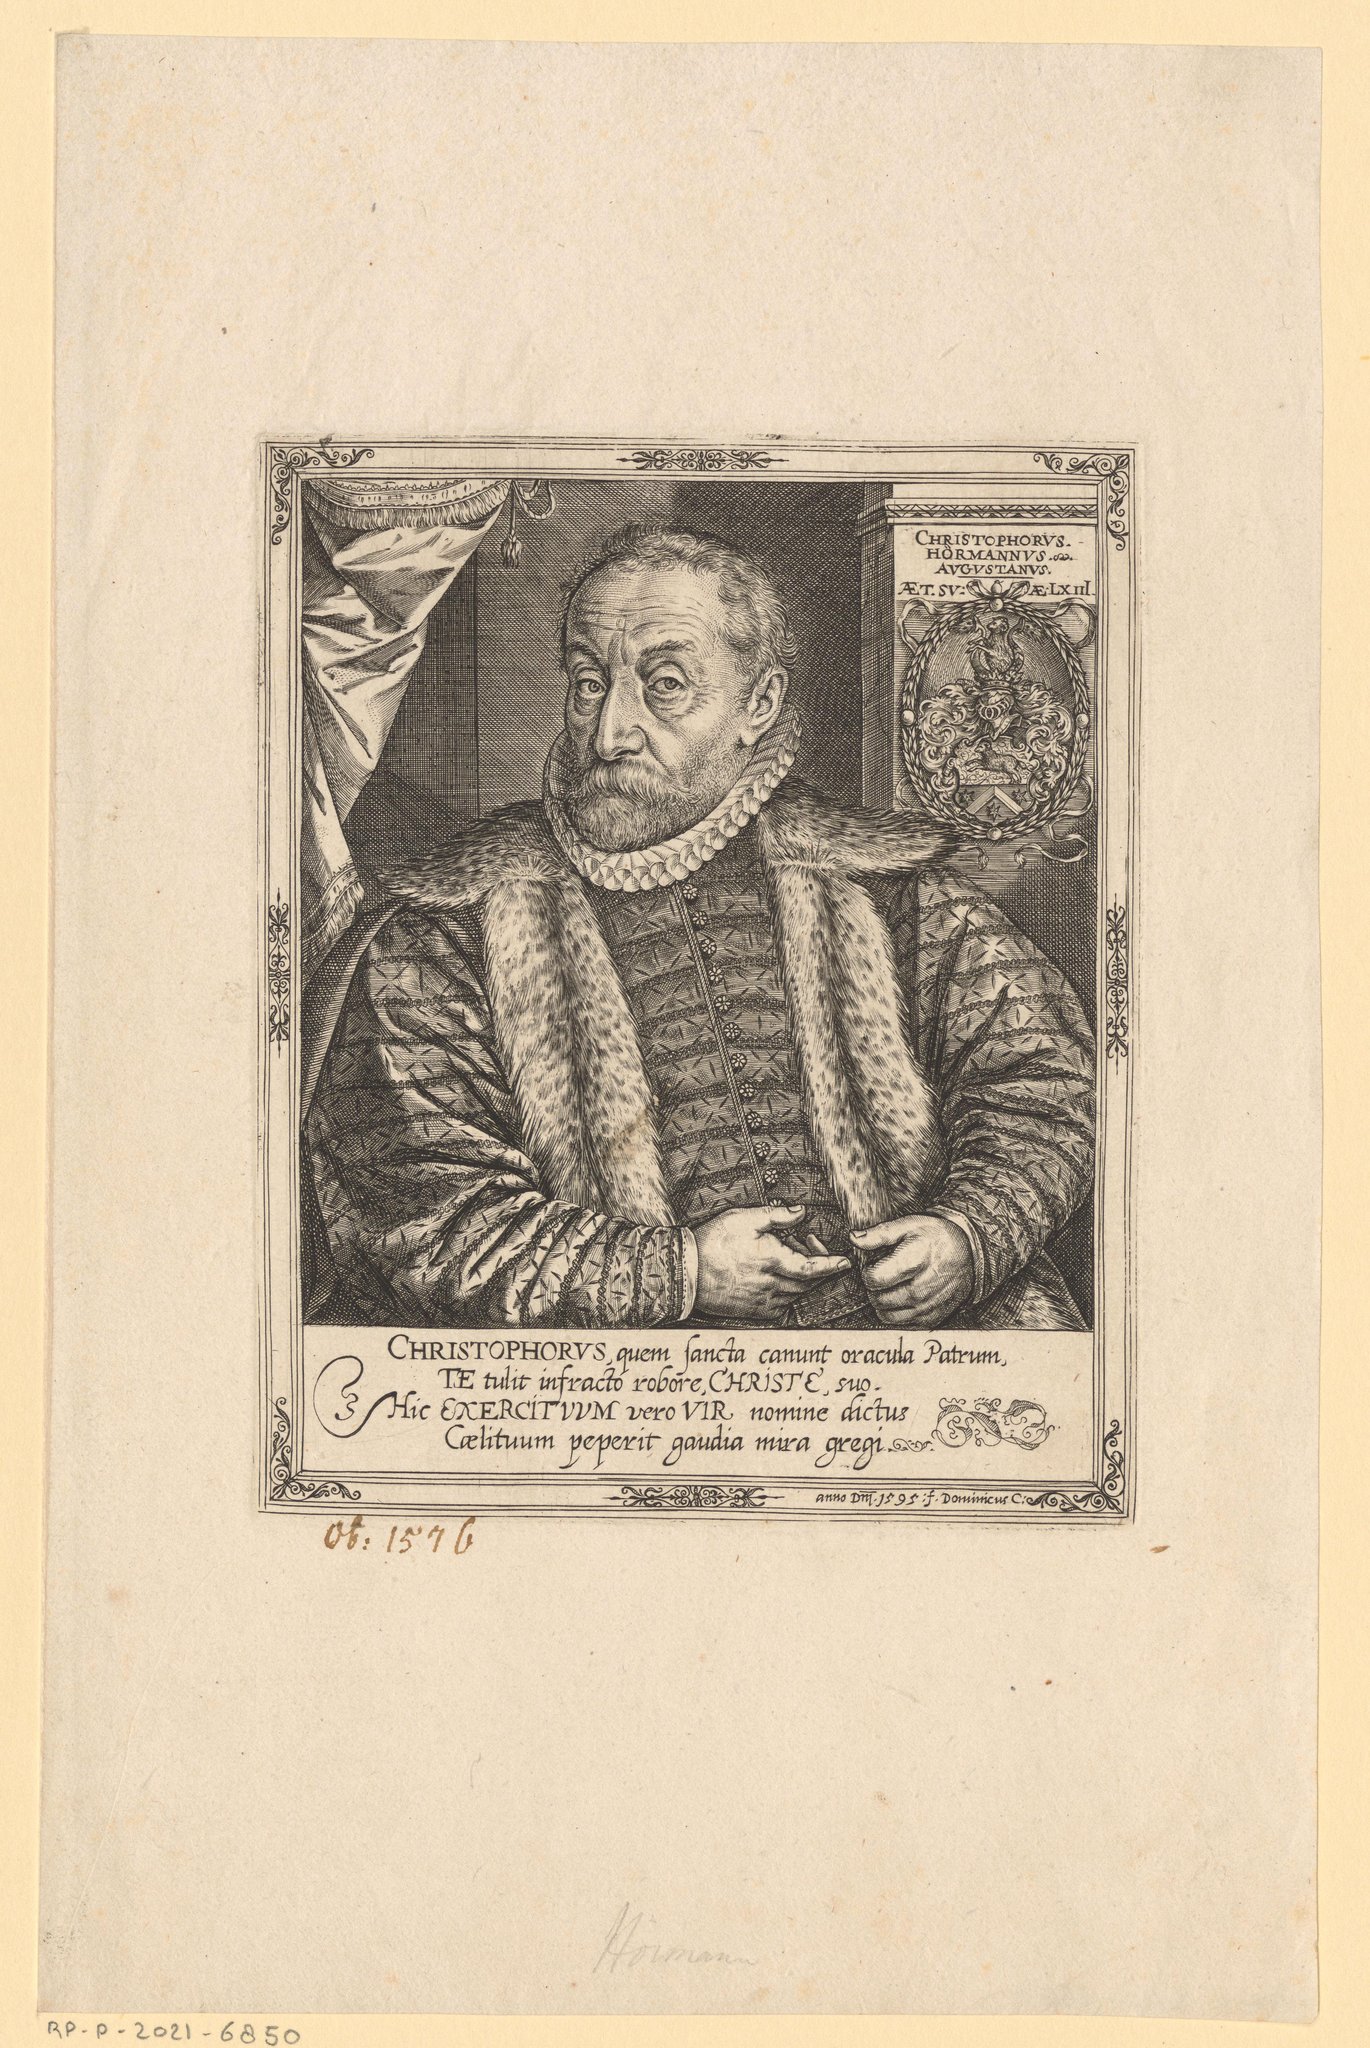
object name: print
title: Portret van Christoph Hörmann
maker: dominicus custos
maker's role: print maker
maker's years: 1560-1615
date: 1595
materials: paper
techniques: engraving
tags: historical persons, armorial bearing, heraldry, merchant, salesman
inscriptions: inscription: ‘Ob: 1576’